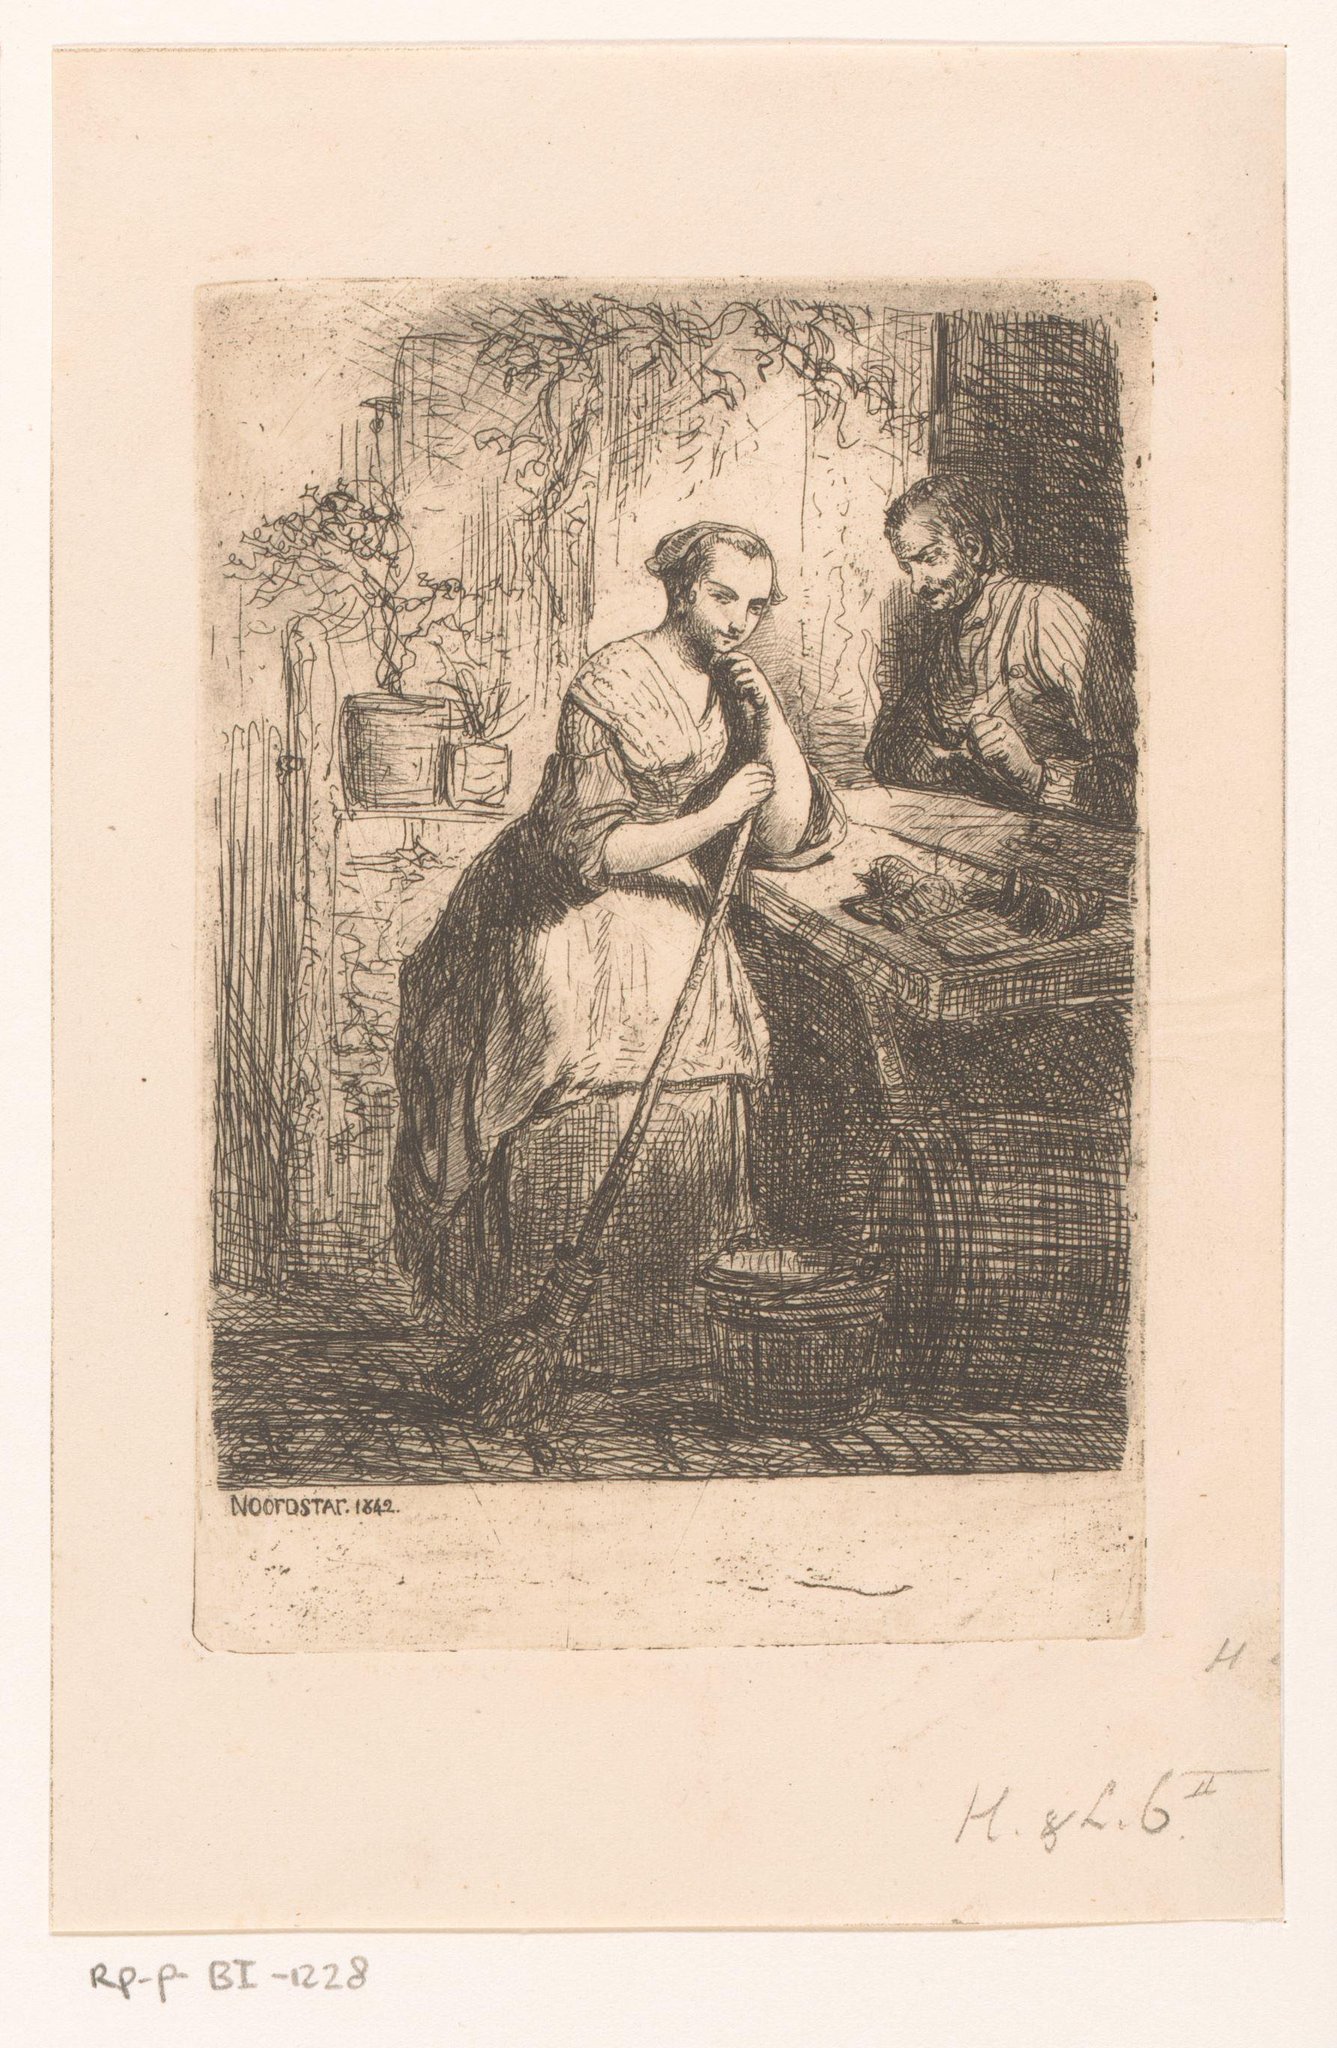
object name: print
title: Jonge vrouw bij een schoenmaker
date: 1842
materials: paper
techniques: etching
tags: adult woman, shoe-maker, cobbler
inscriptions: collector's mark: Lugt 2228